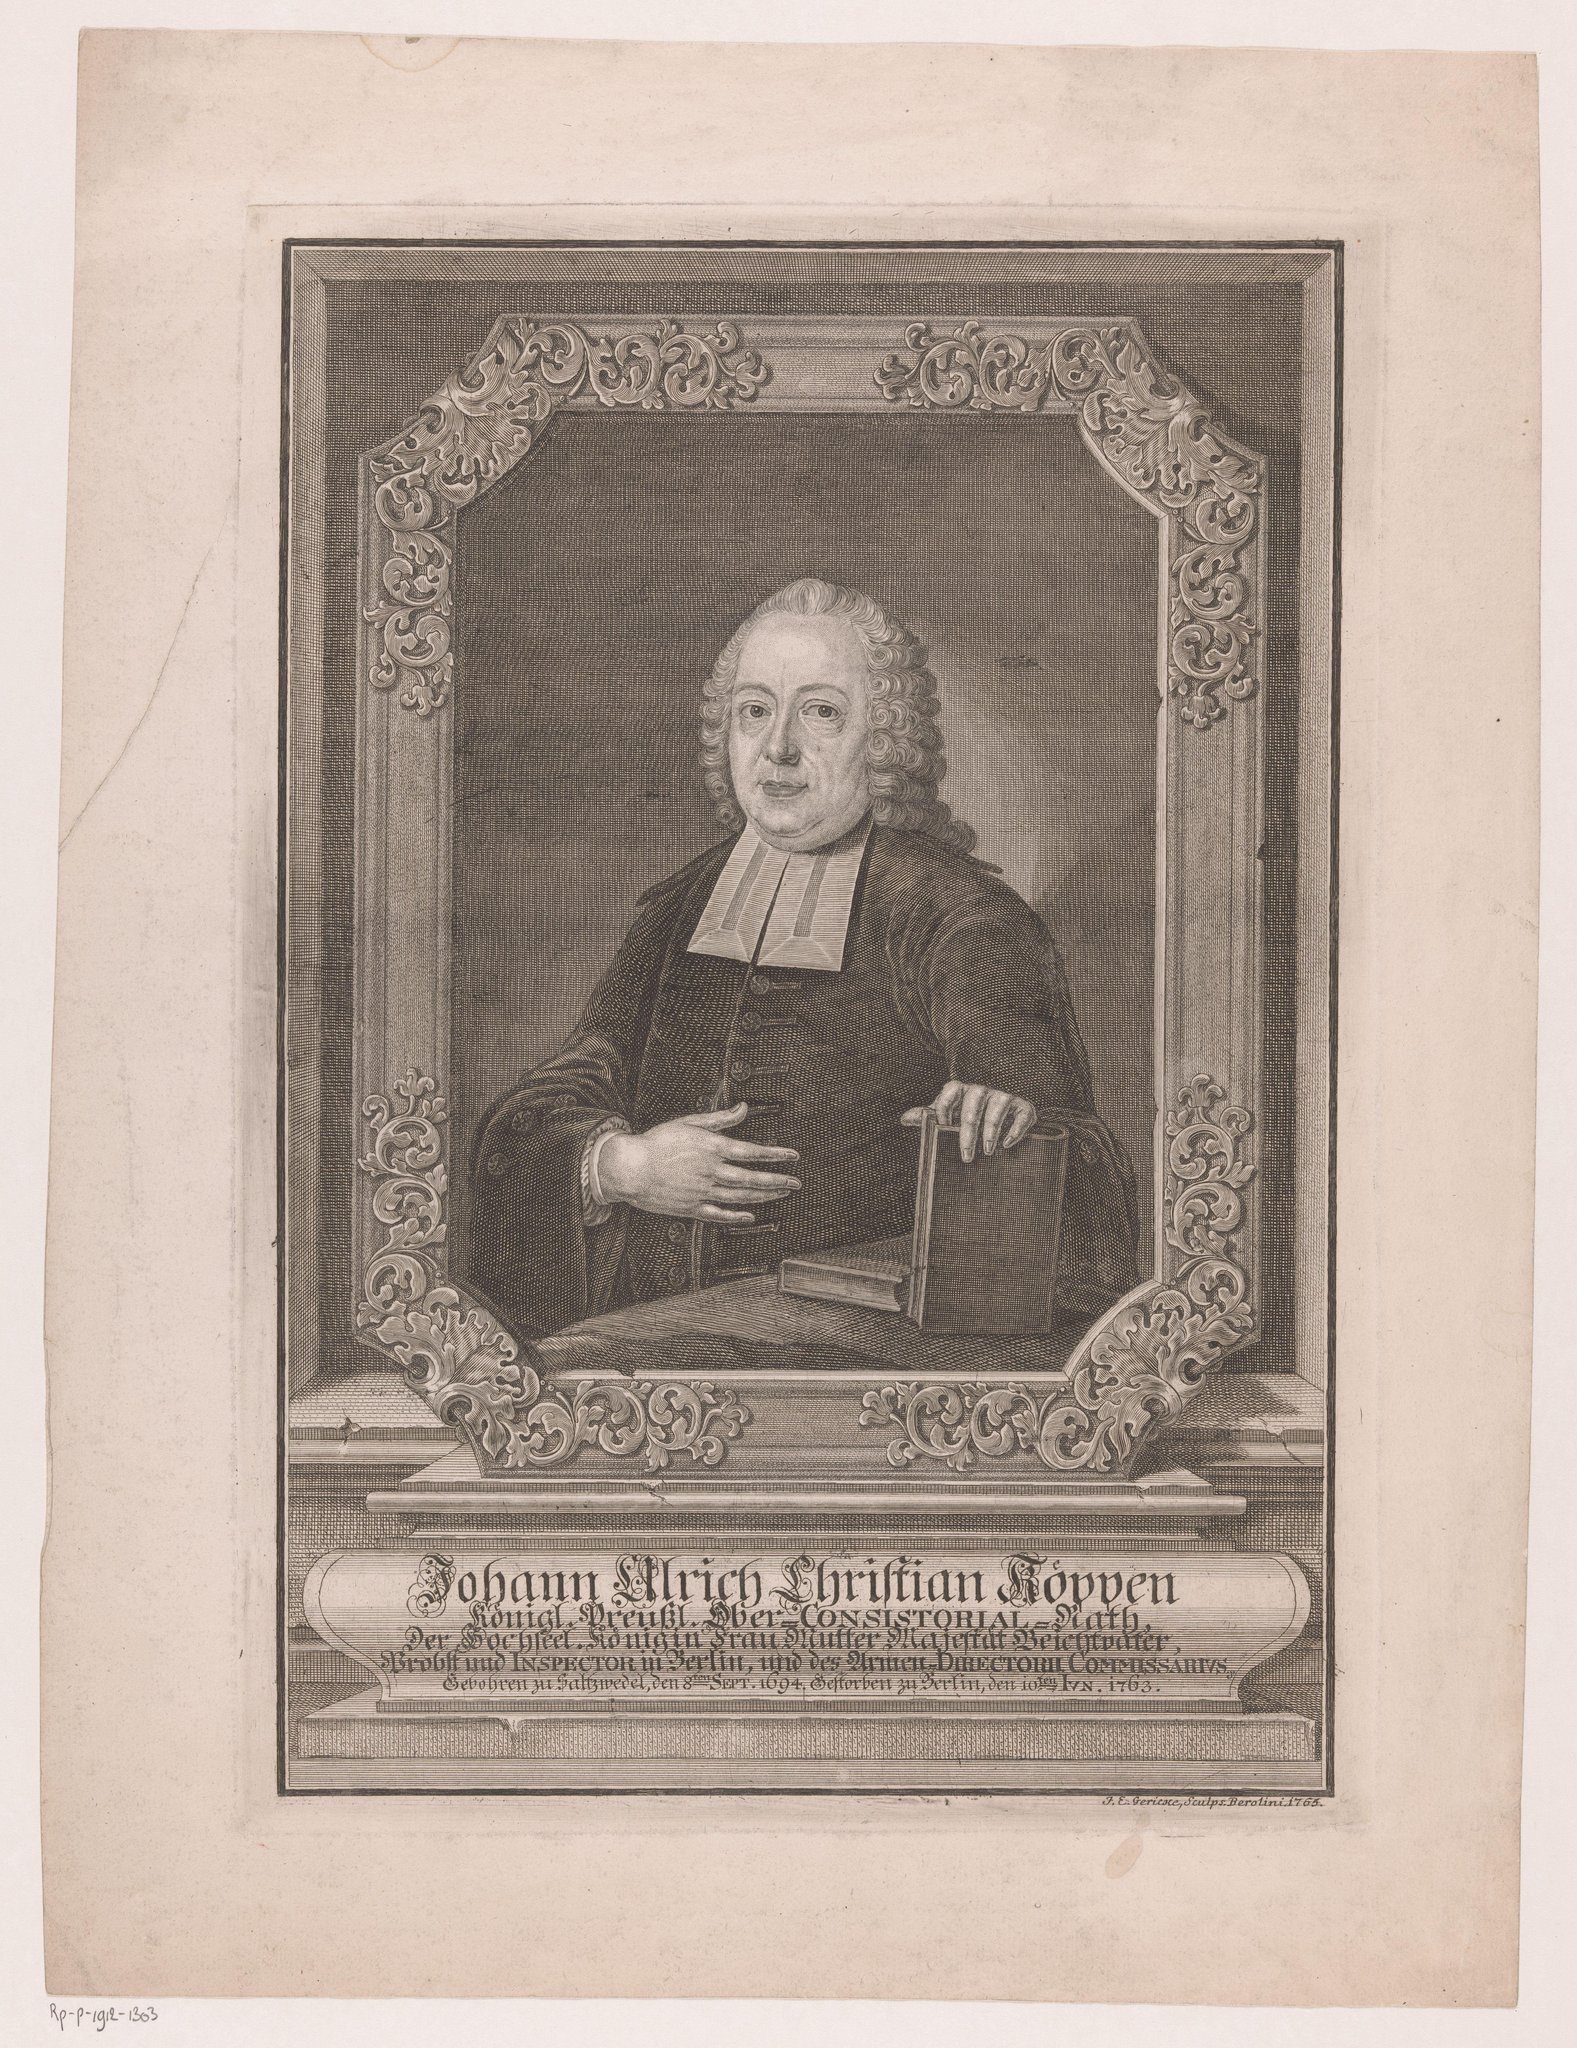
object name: print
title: Portret van Johann Ulrich Christian Köppen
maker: johann ernst gericke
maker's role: print maker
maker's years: 1726-1785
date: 1765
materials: paper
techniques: engraving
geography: berlin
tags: berlin, theologian, historical persons, book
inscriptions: collector's mark: Lugt 2228